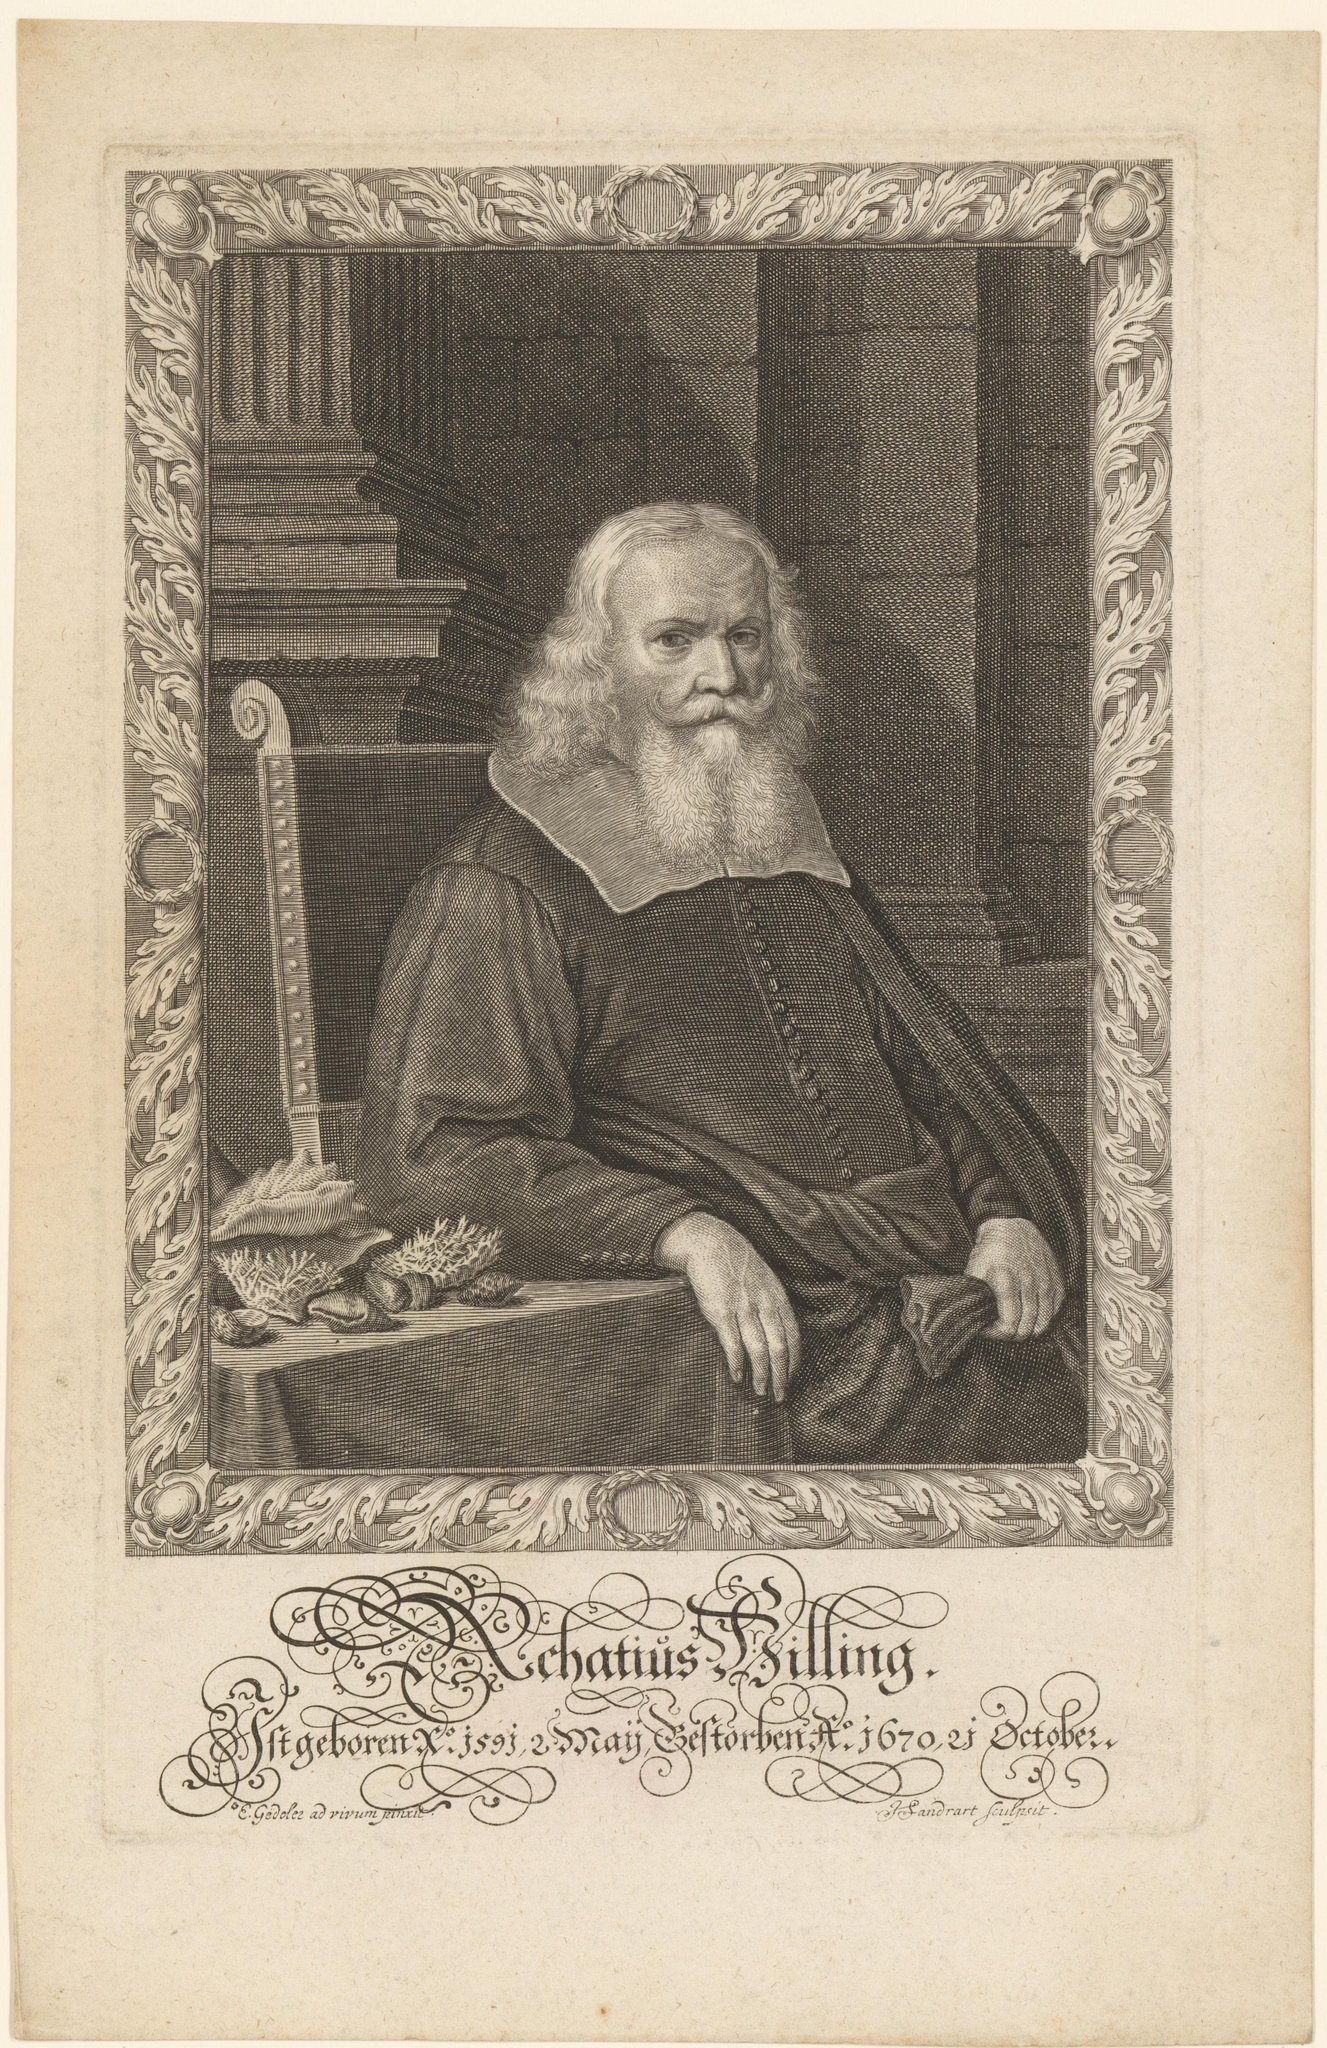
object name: print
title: Portret van Achaz Hilling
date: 1671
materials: paper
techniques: engraving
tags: coelenterata: coral, historical persons, molluscs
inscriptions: collector's mark: Lugt 2228